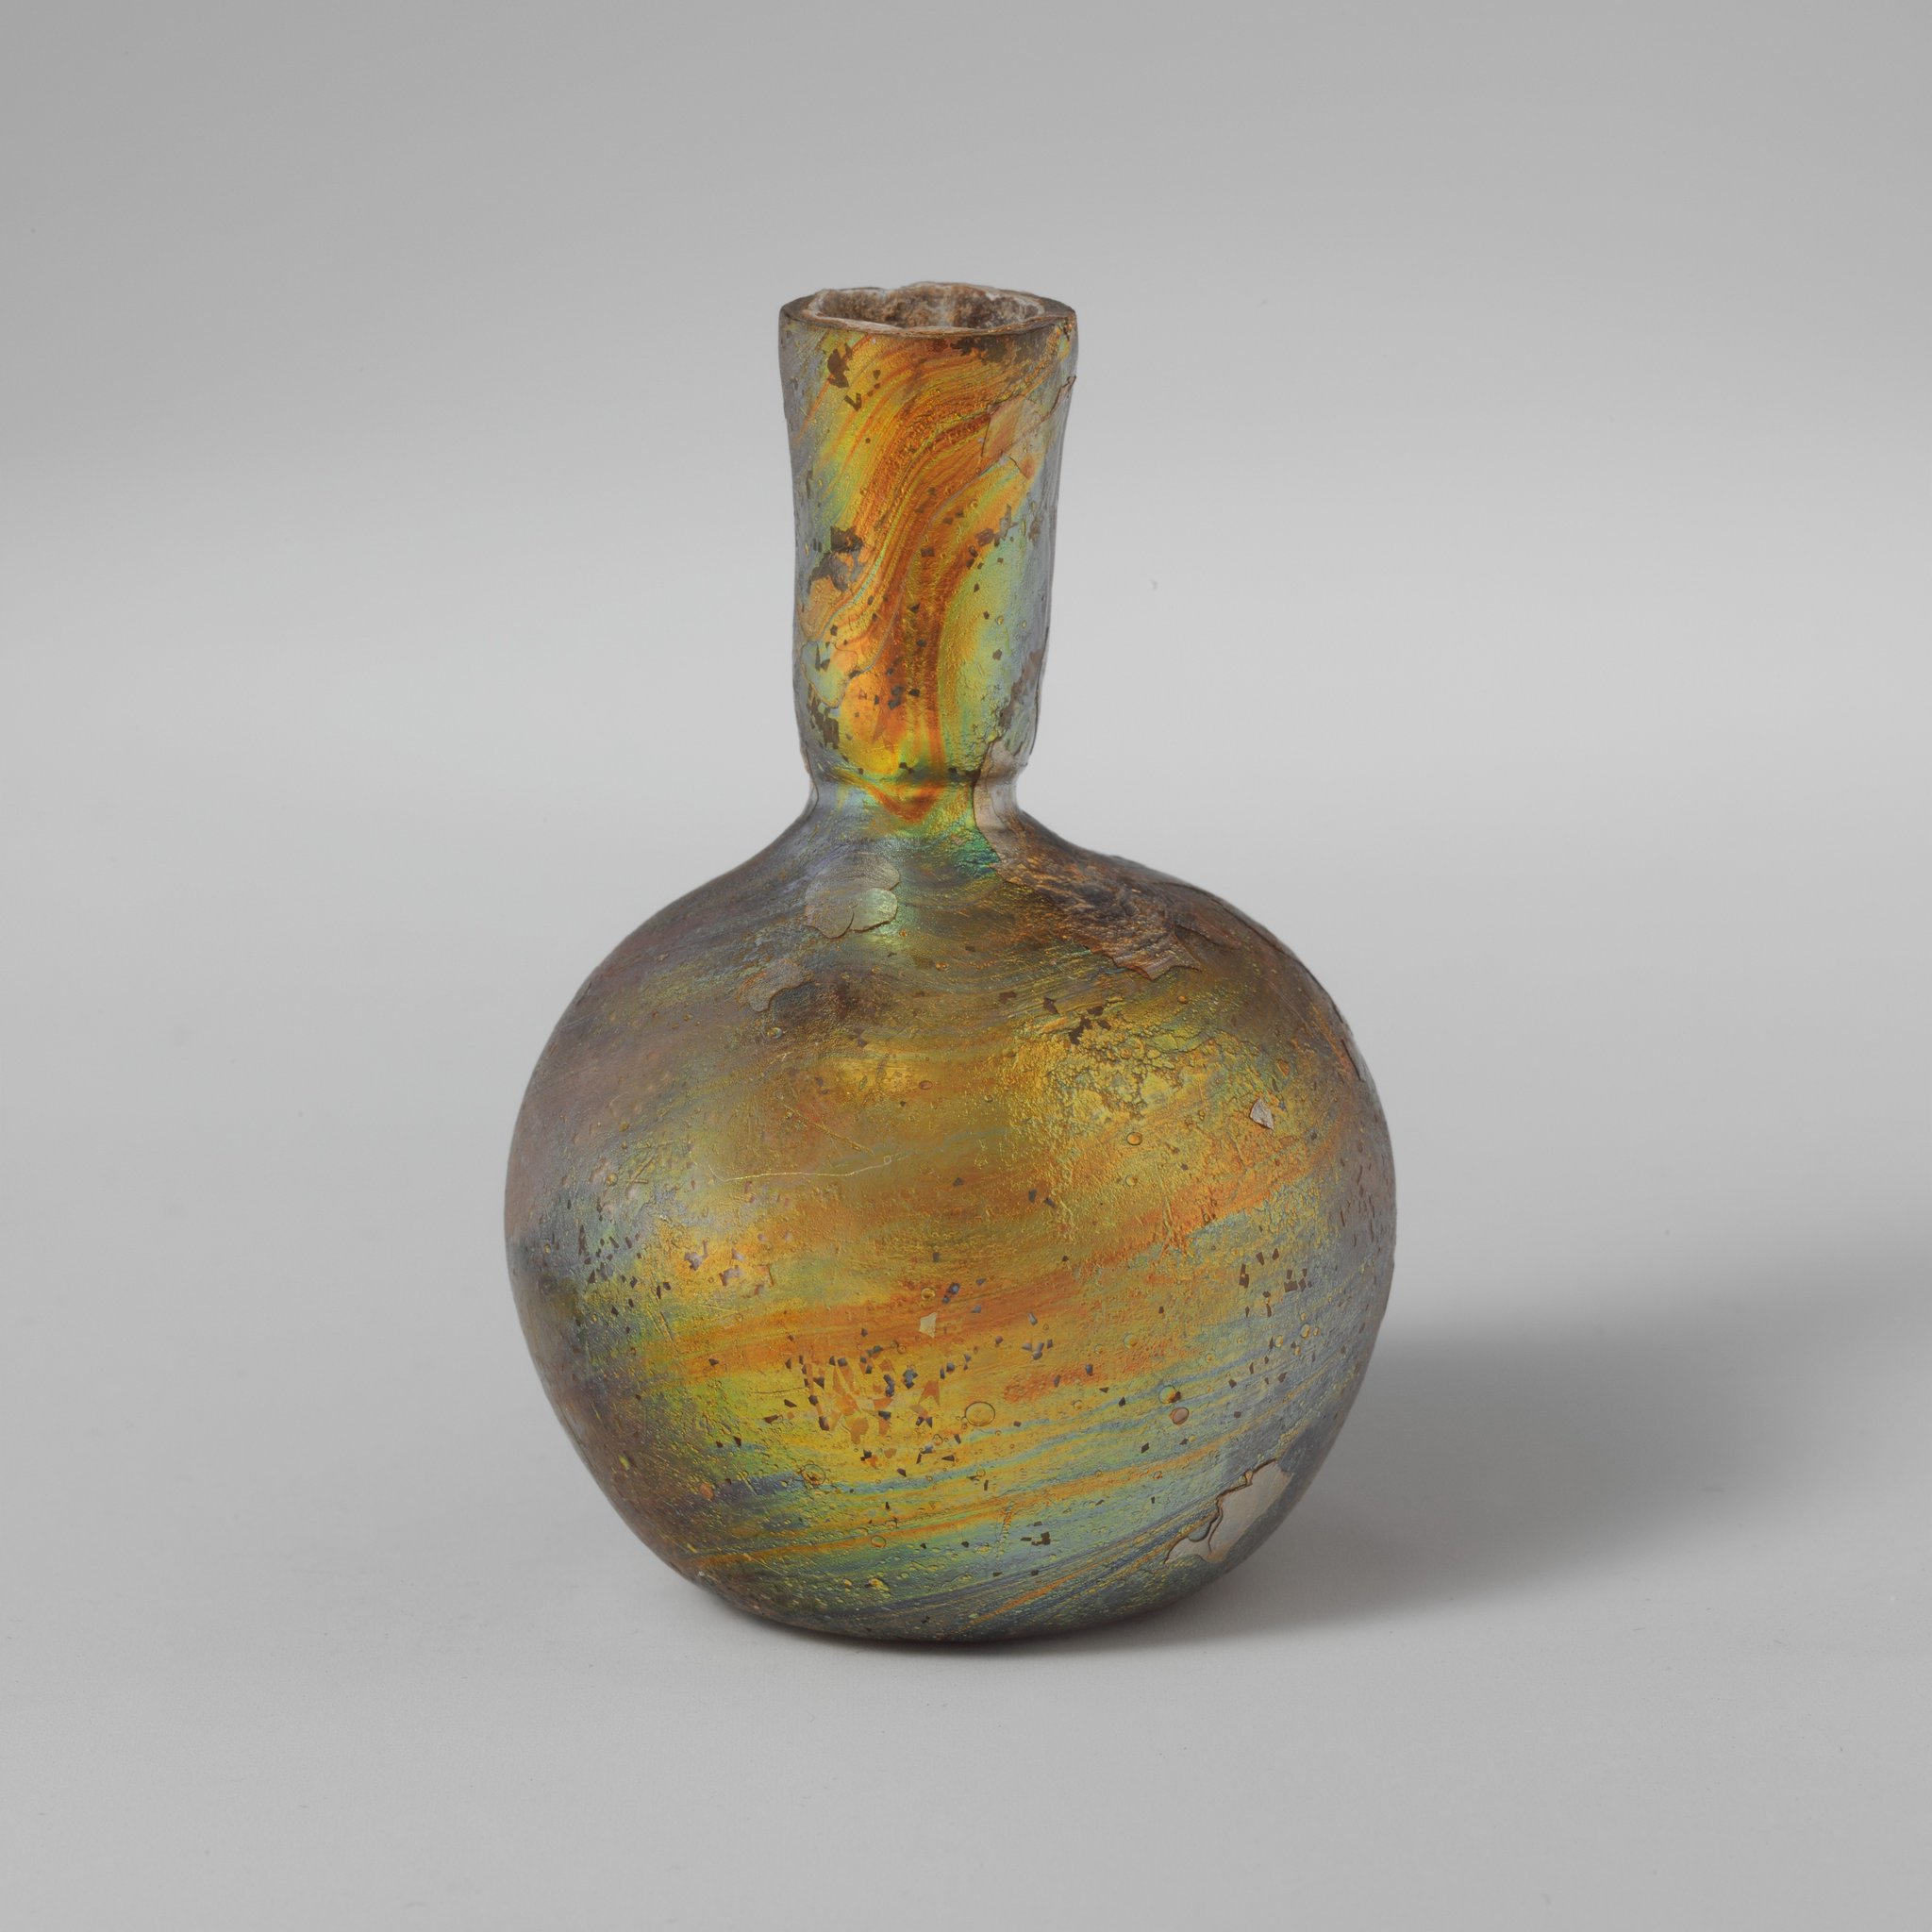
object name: flask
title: Glass miniature flask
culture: roman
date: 201-400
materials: glass